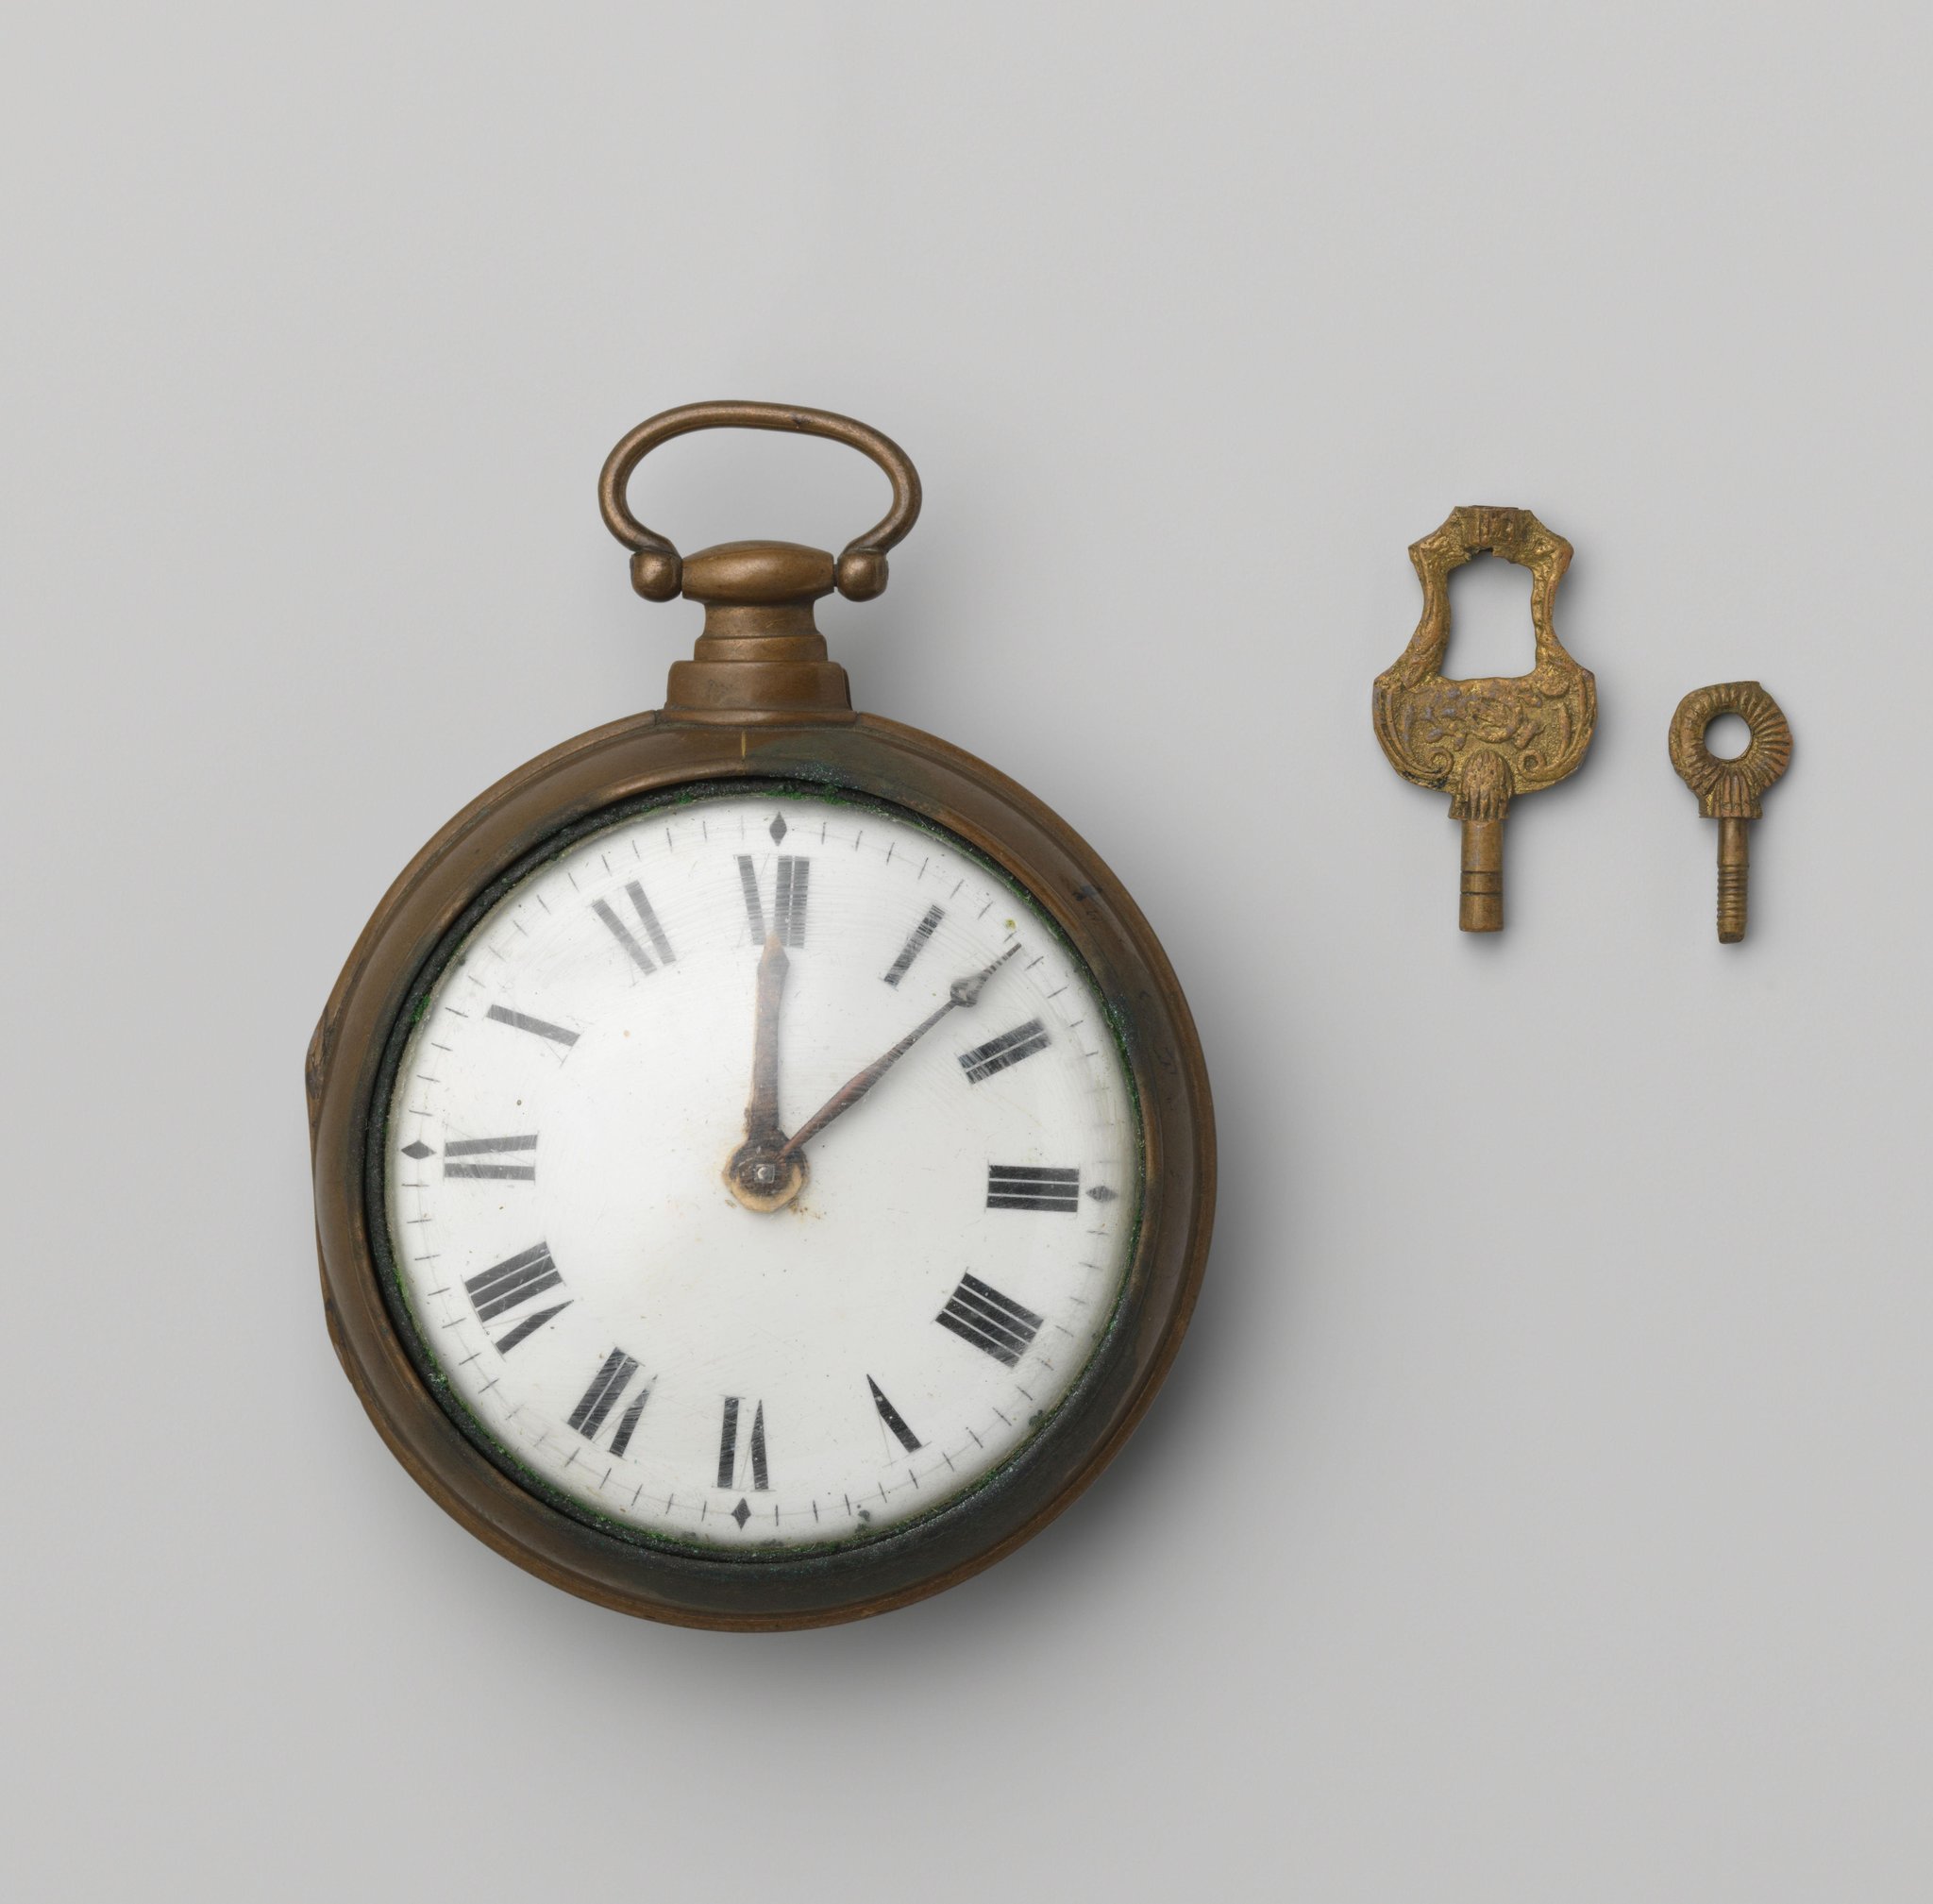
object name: jewellery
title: Zakhorloge met wit geëmailleerde wijzerplaat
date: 1700-1800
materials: copper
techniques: gilding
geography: amsterdam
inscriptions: retailer's mark: ‘Rijn:r van Vlijmen horlogemaker op de Urechtse straat, het tweede huis van de Herengracht 10, Amsterdam’, retailer's mark: ‘J.C. Göller, Horlogemaker, Nieuwmarkt bij de Bavorde steeg 24, Amsterdam.’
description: Verguld koperen horloge, met wit geëmailleerde wijzerplaat. Met twee sleuteltjes aan koord.